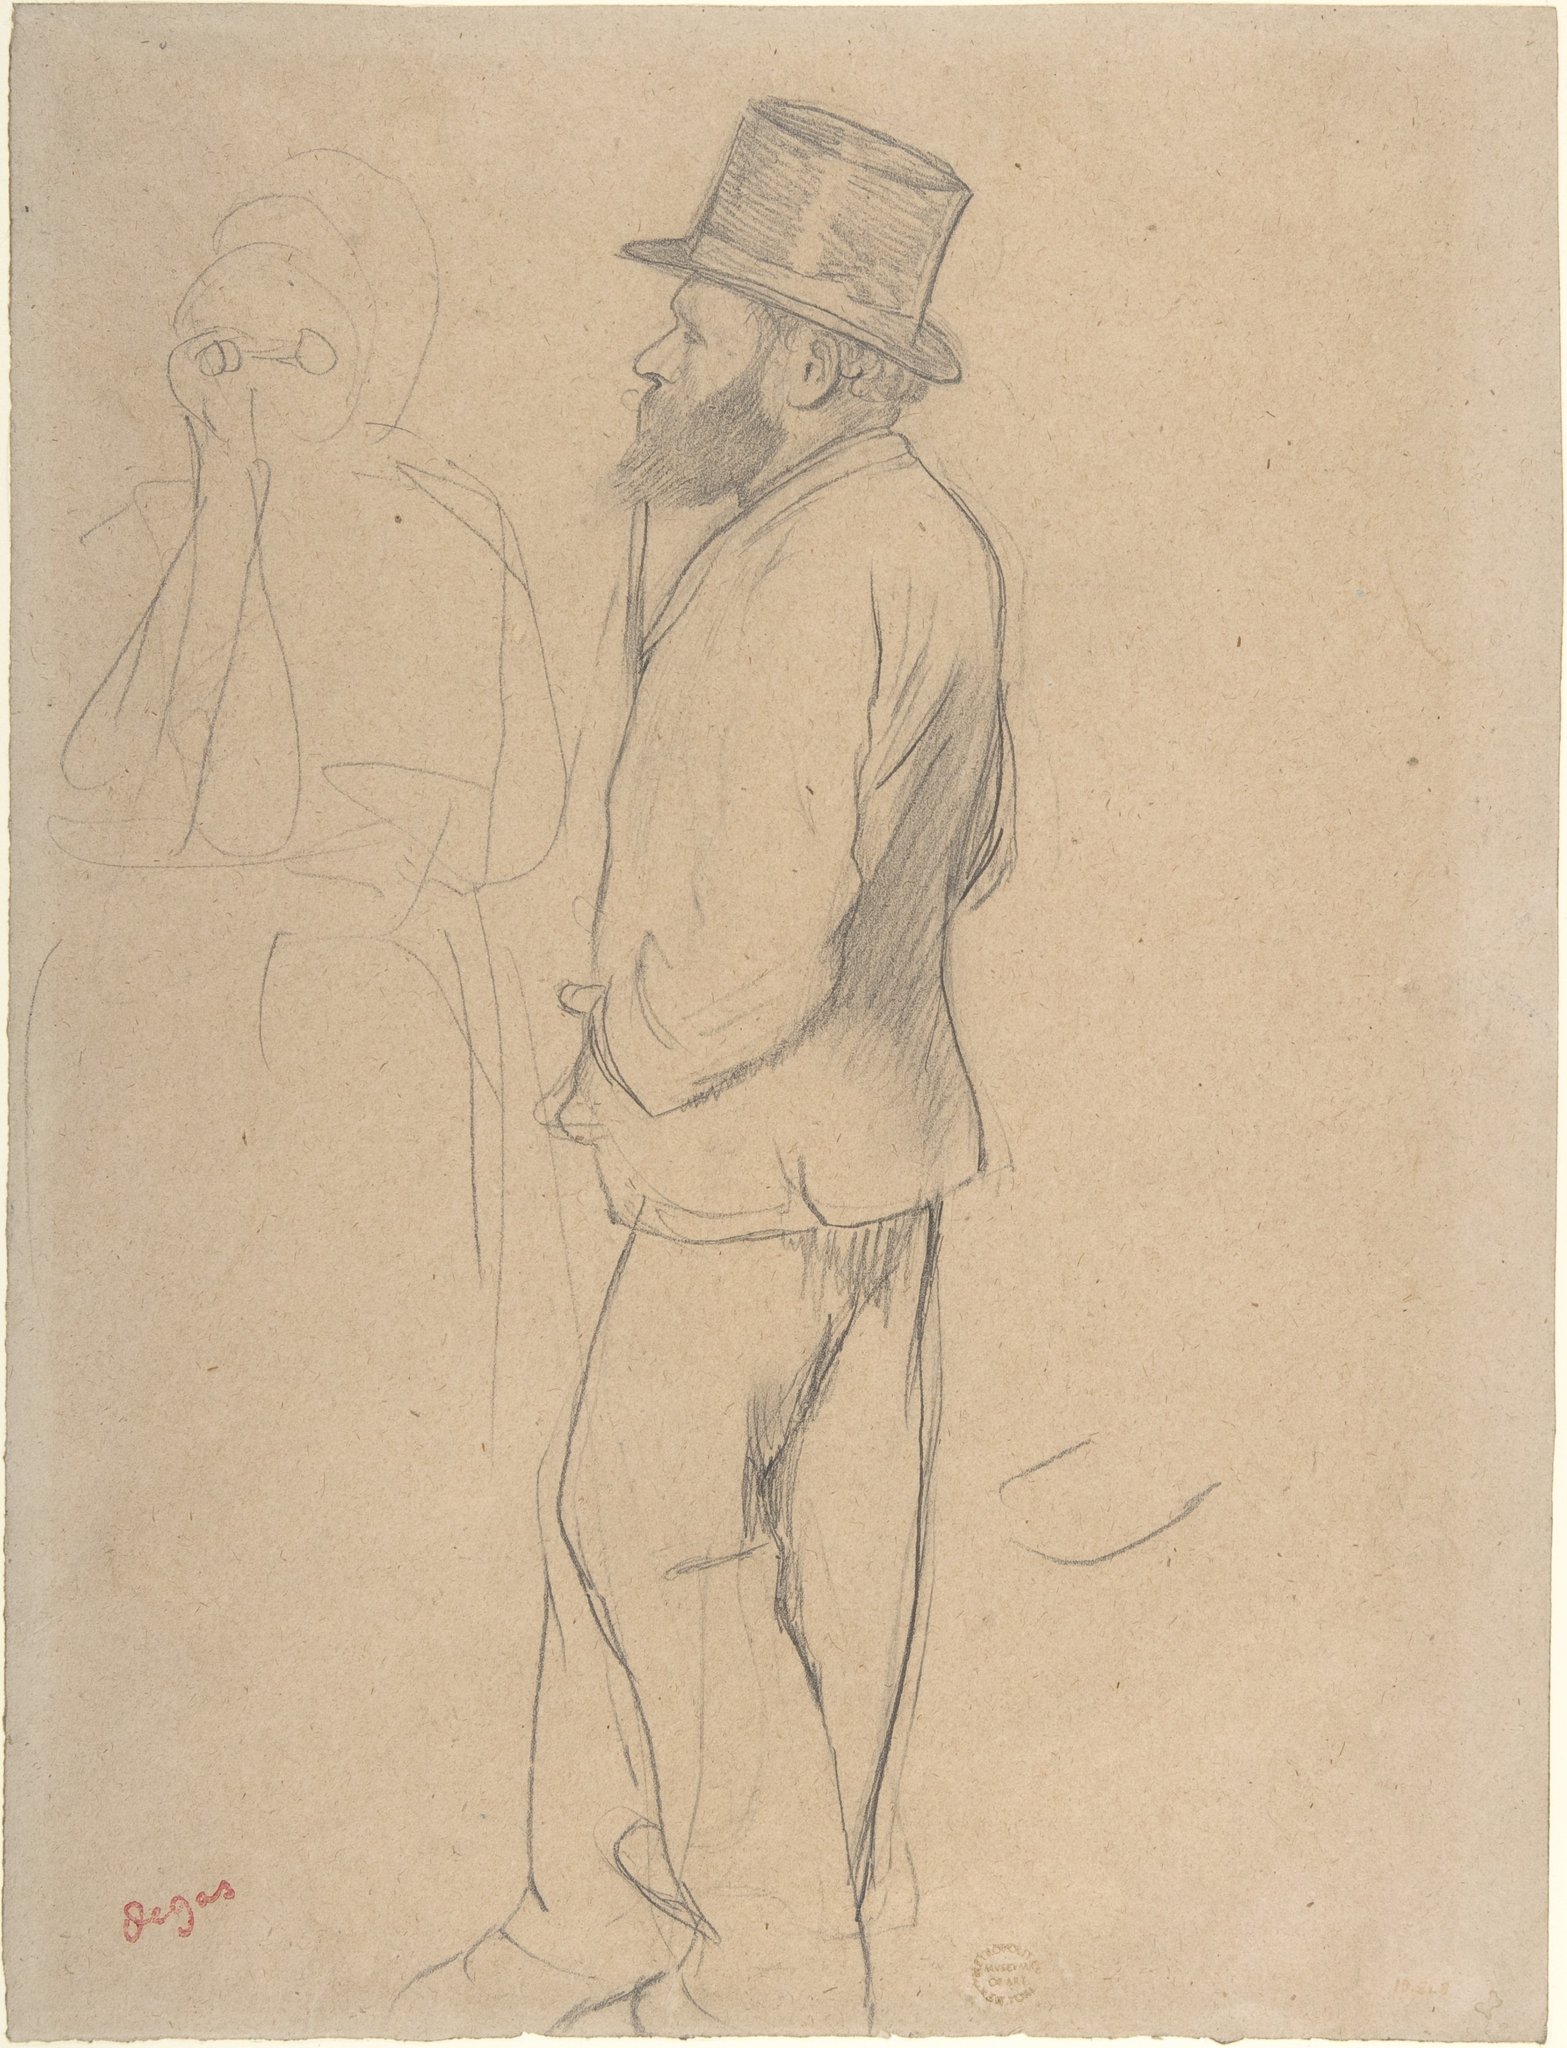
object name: drawing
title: Édouard Manet at the Races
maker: edgar degas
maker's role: artist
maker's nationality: french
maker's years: 1834-1917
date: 1868-1869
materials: chalk, graphite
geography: france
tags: men